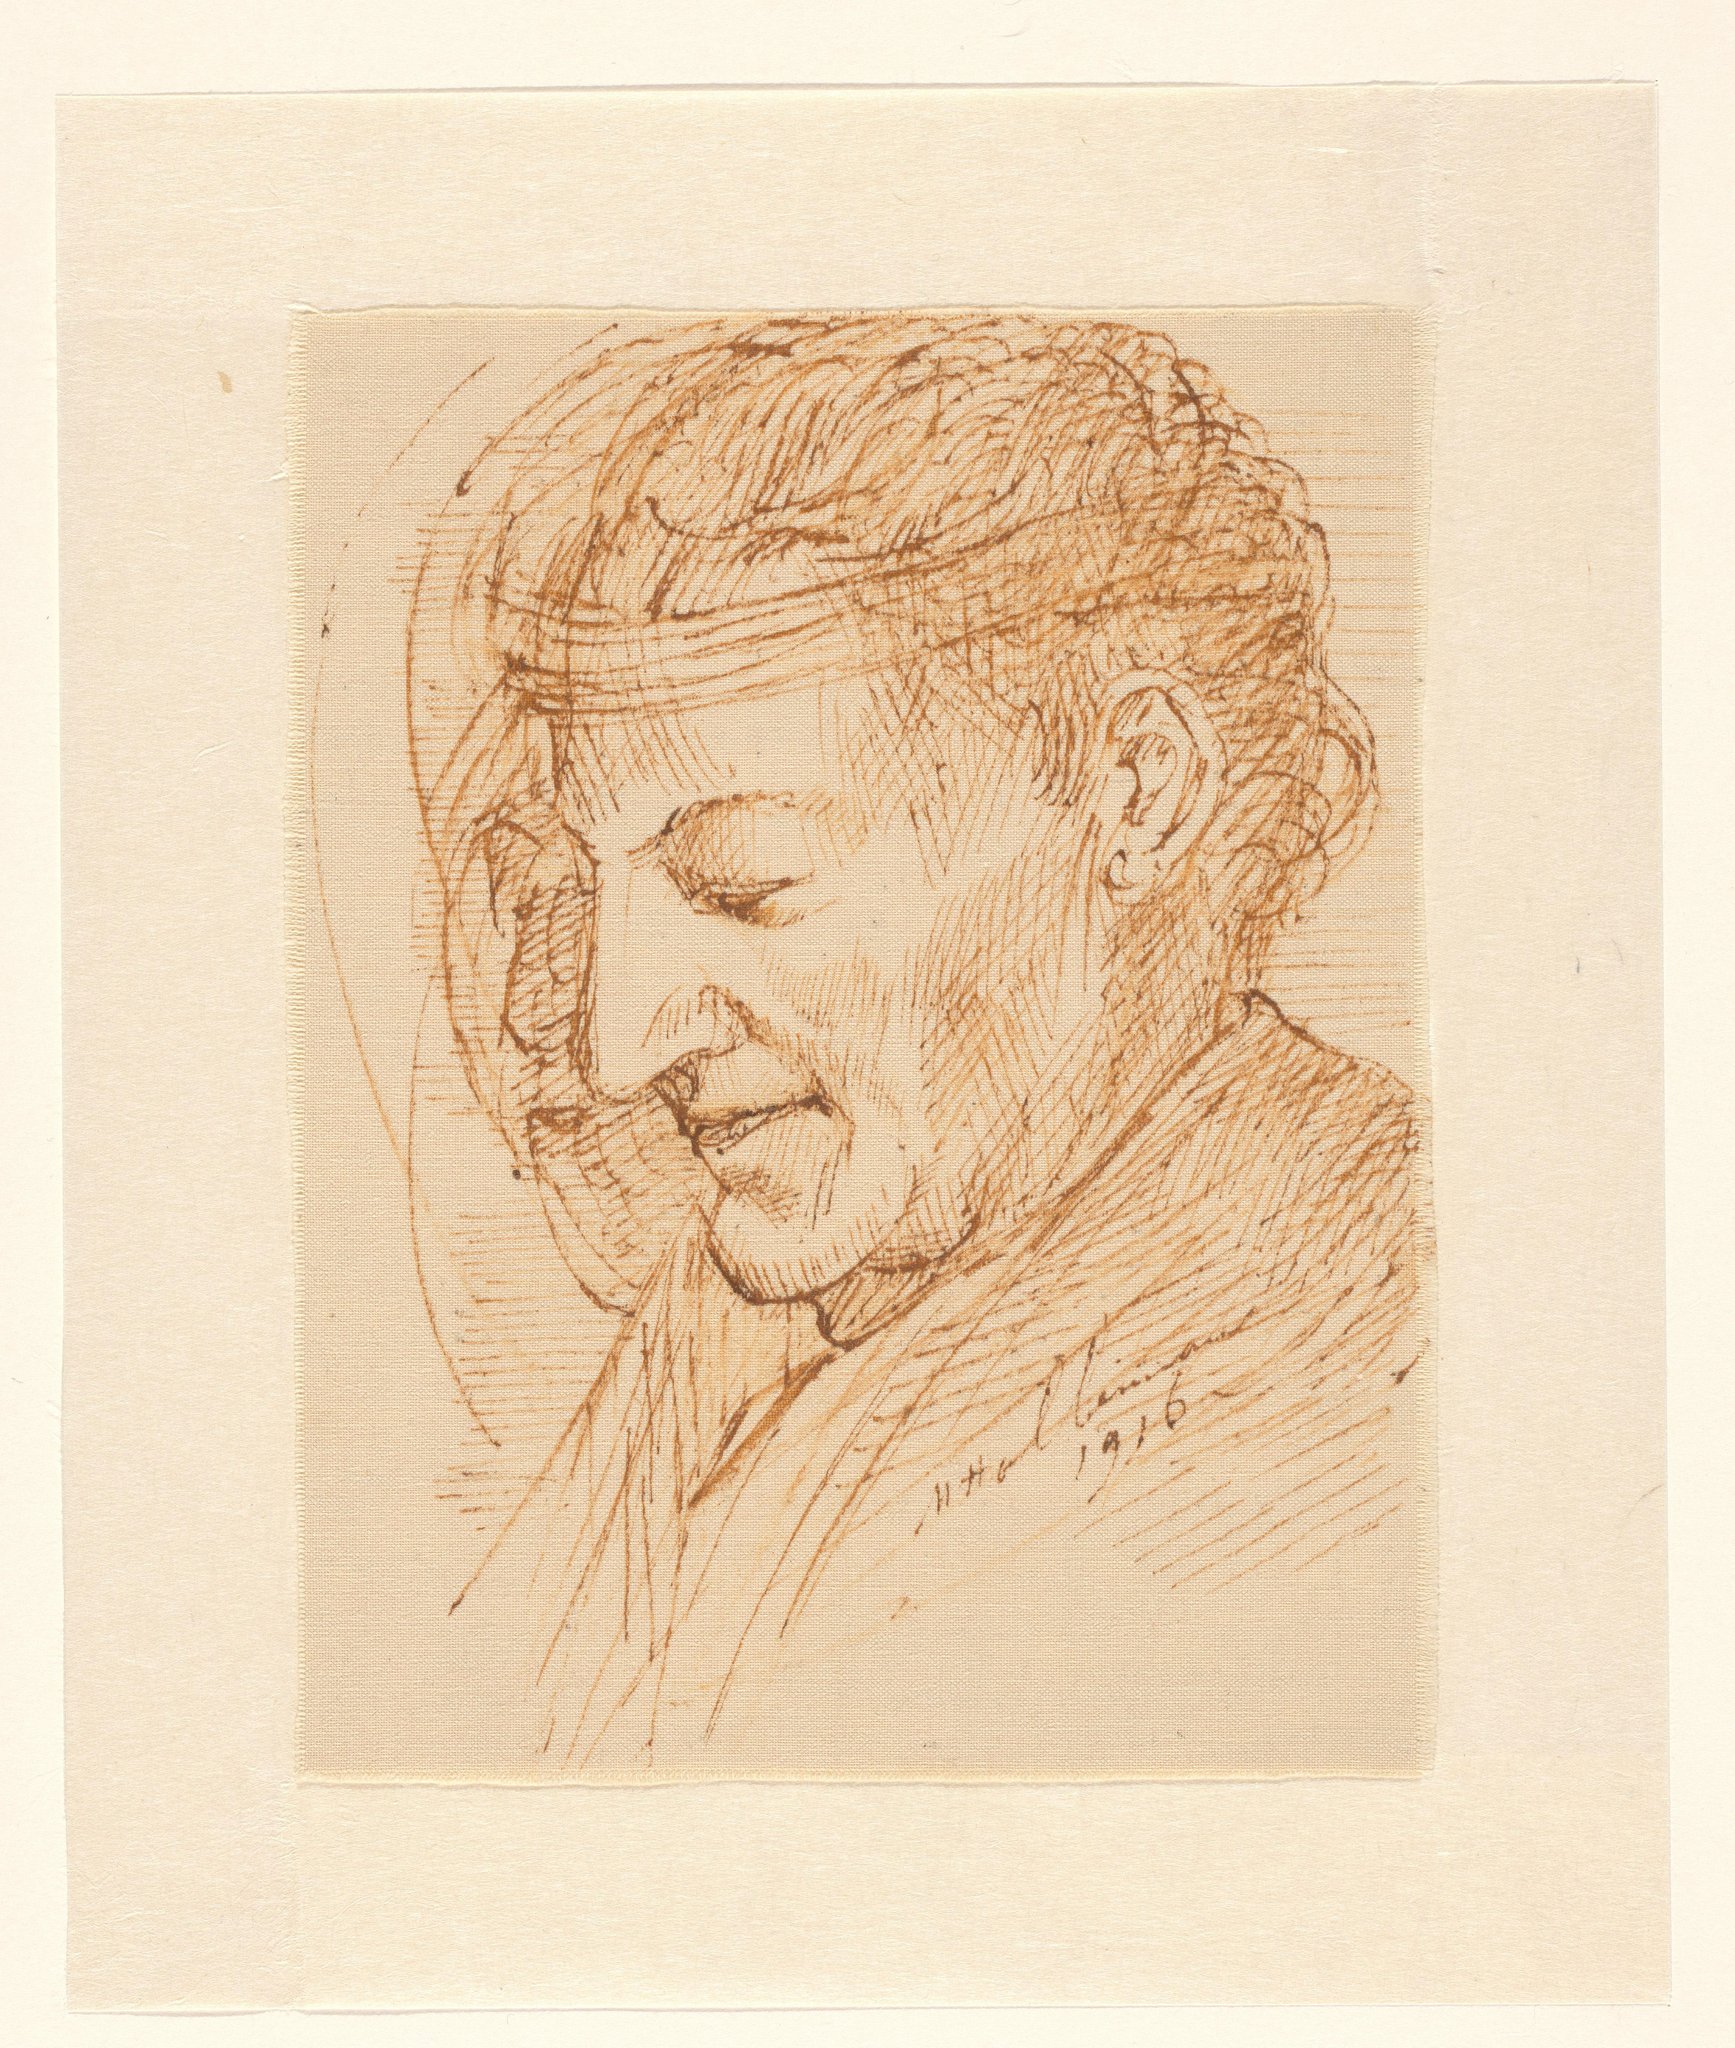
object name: drawing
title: Kop van een man met neergeslagen ogen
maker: marius holleman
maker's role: draughtsman, print maker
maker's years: 1878-1926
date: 1916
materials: ink, linen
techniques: pen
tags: head (human), eyes closed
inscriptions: date